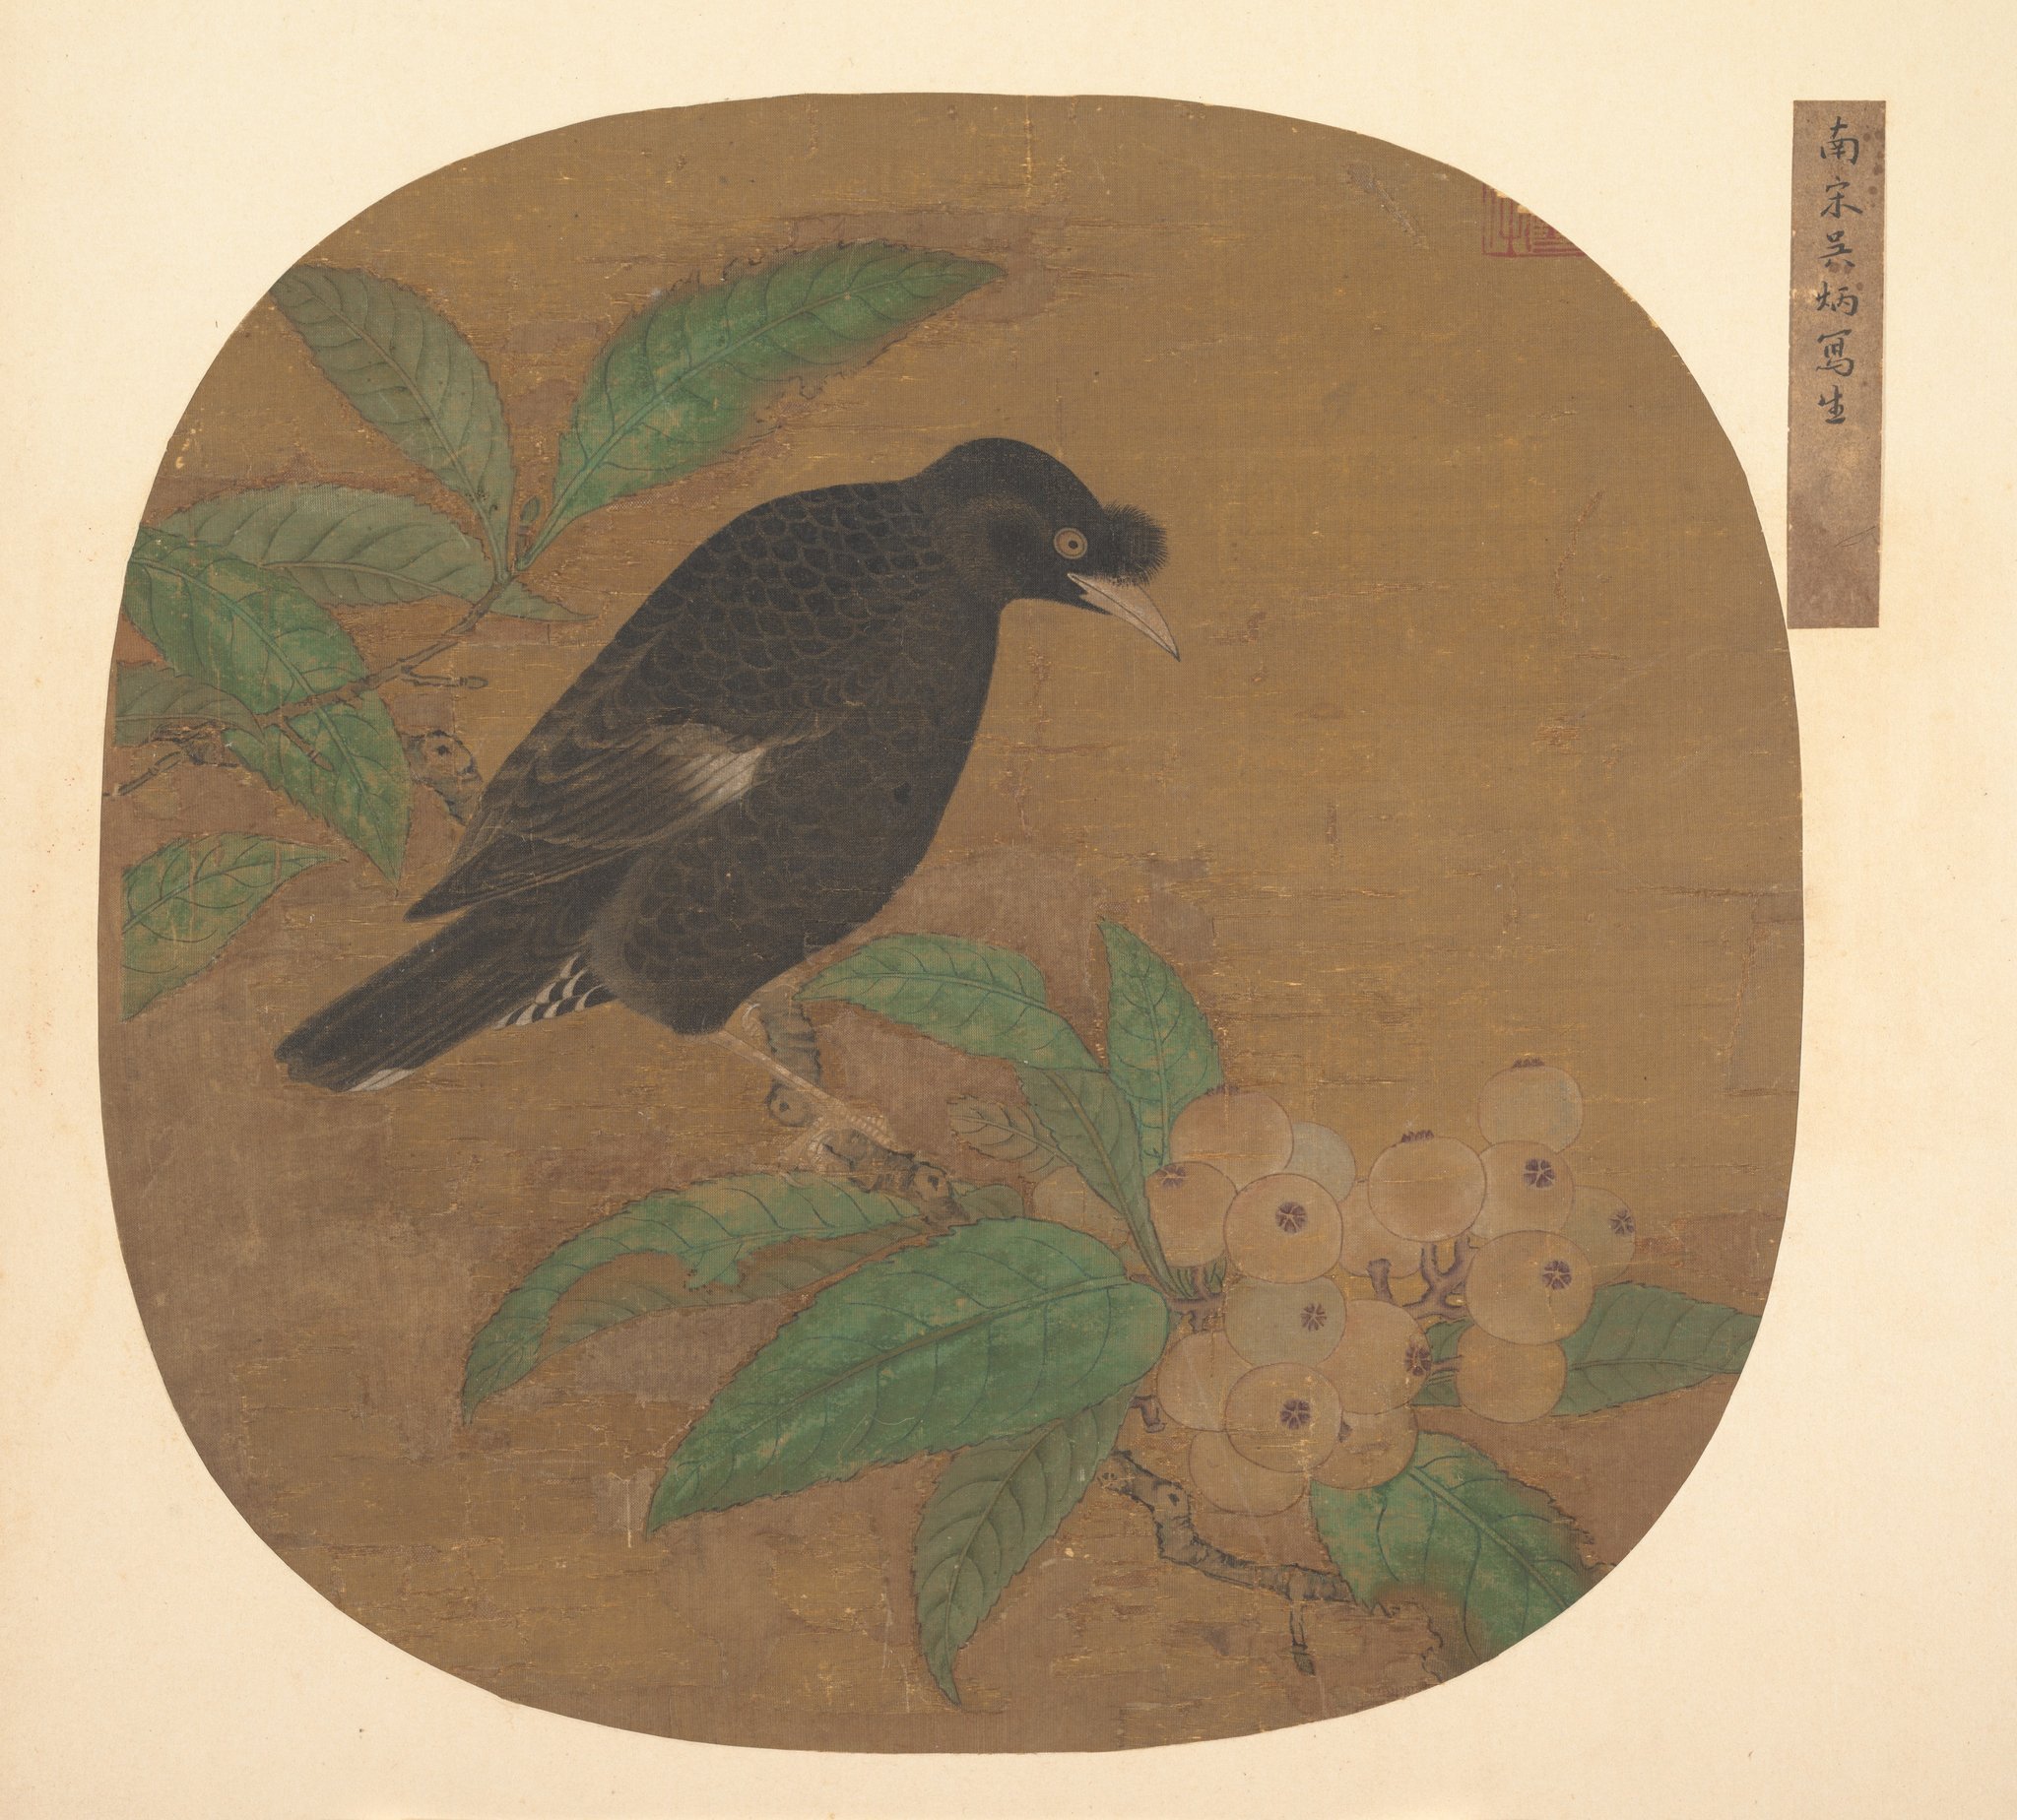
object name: fan mounted a an album leaf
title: Minah Bird on a Loquat Branch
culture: chinese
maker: unidentified artist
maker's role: artist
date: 960-1300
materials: ink, silk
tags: birds,fruit